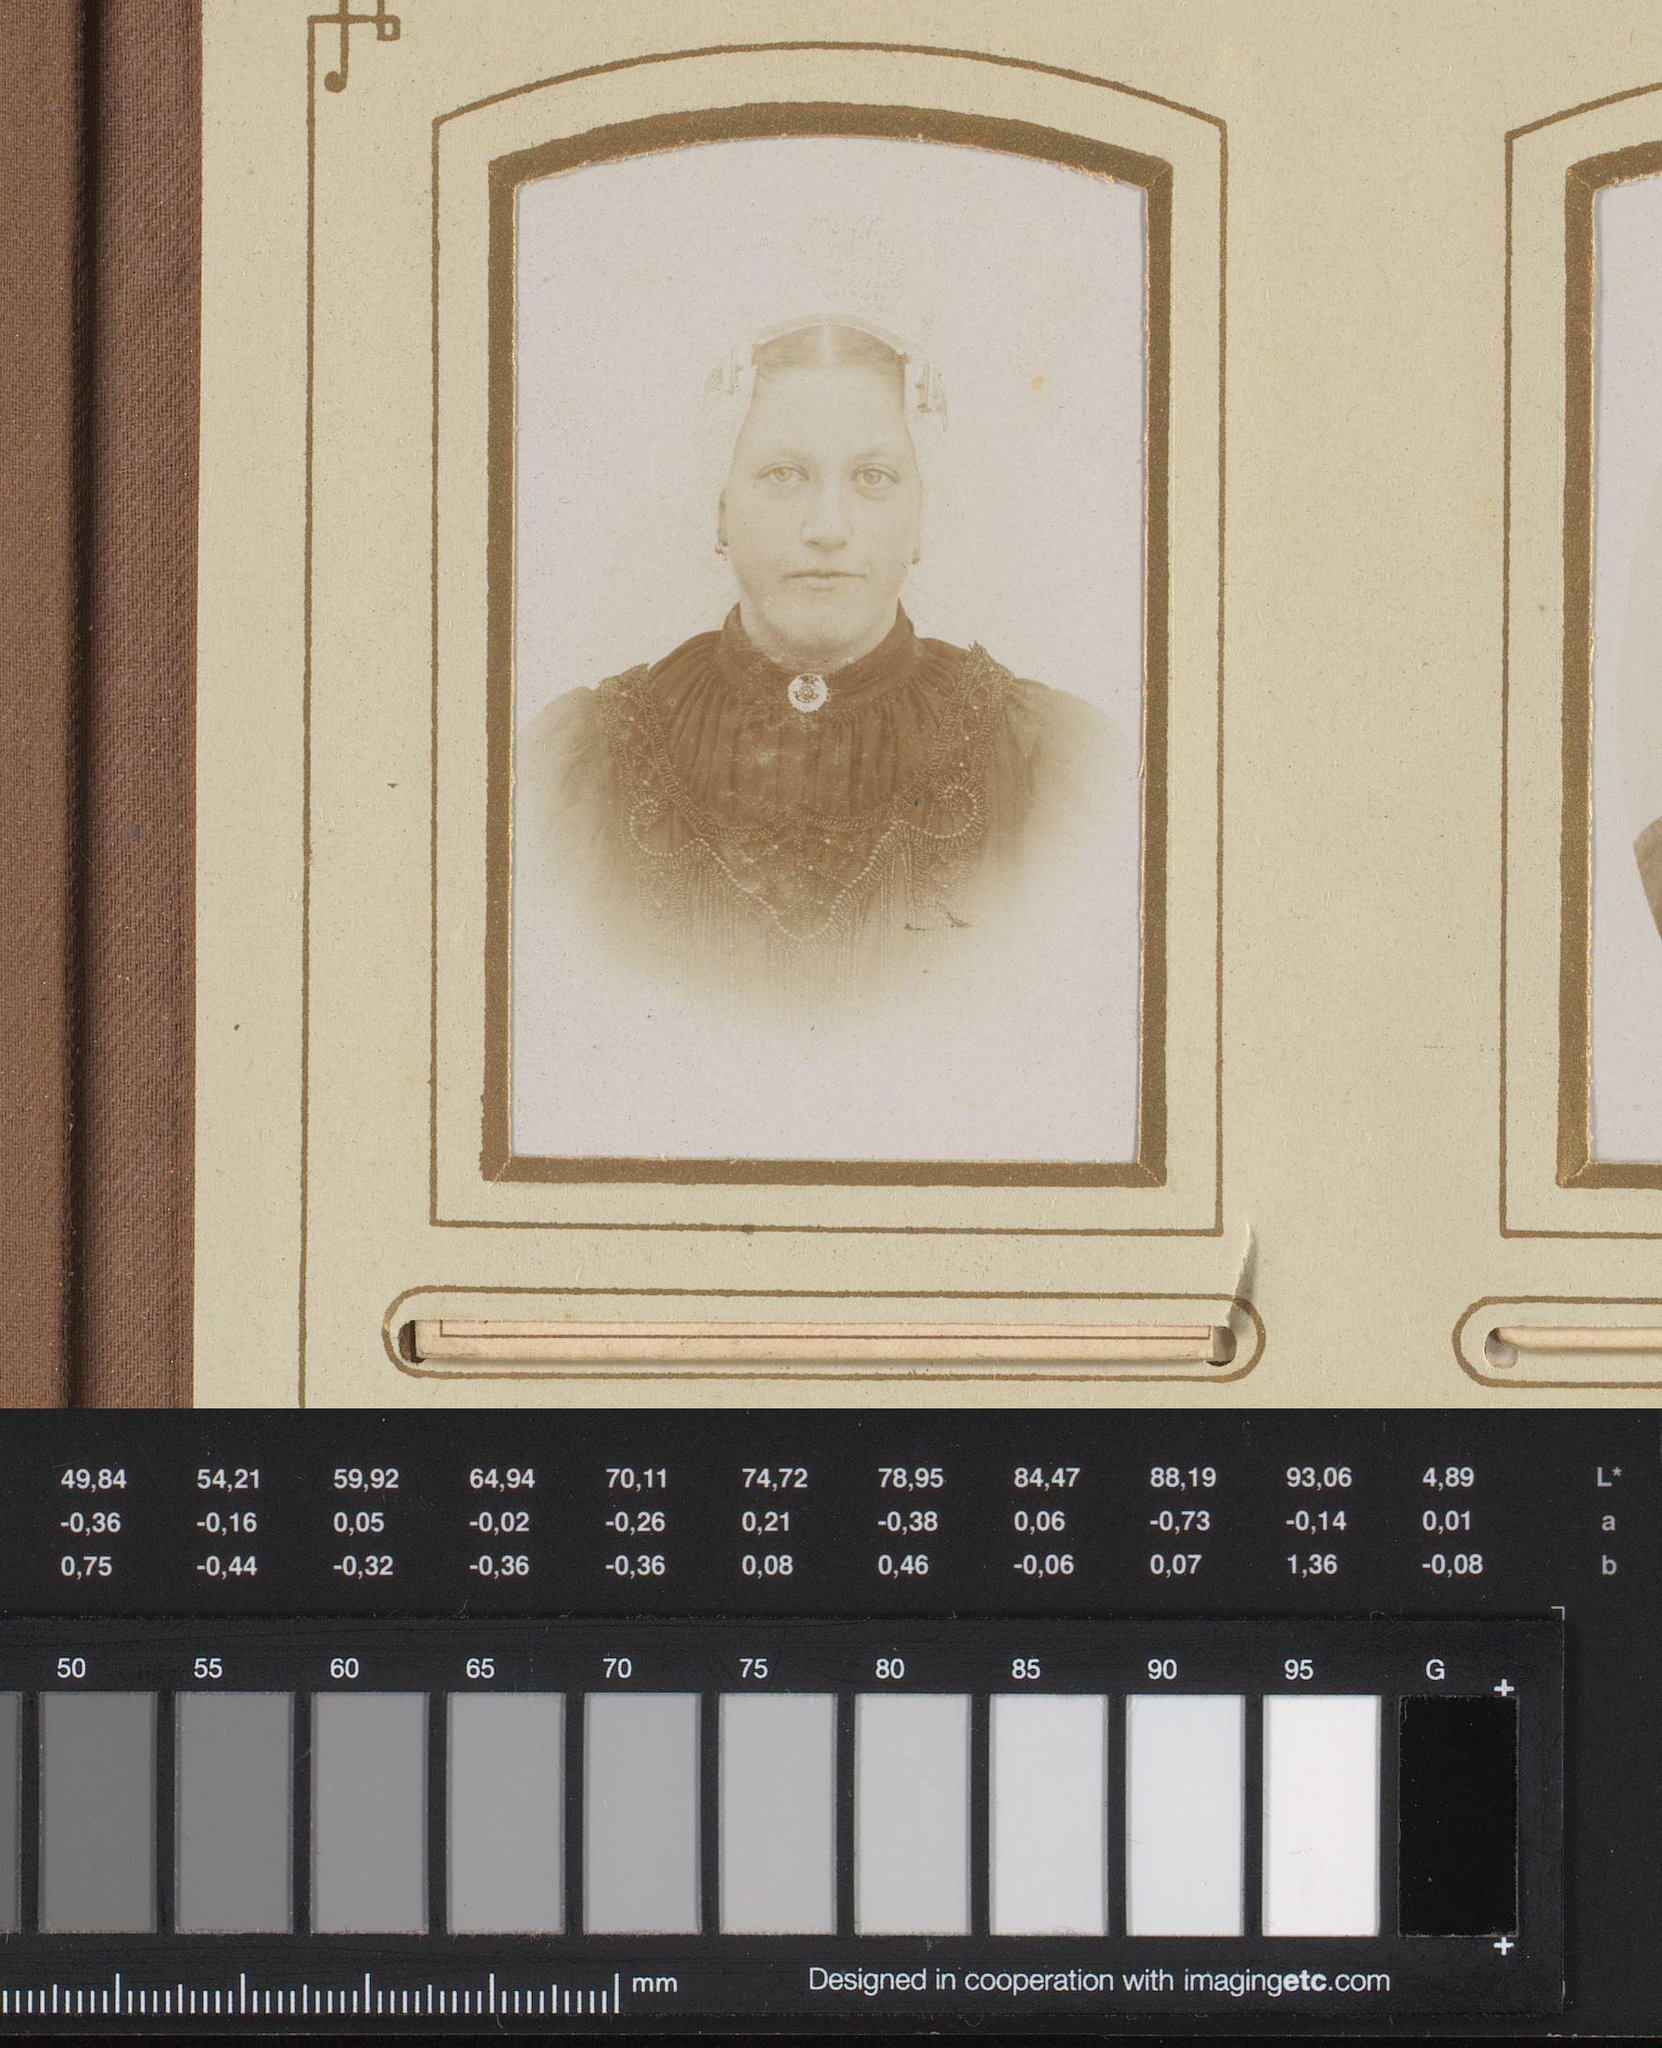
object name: photograph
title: Portret van een vrouw met witte klederdrachtmuts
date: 1890-1910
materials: cardboard, photographic support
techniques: collodion silver print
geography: amsterdam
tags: historical persons - bb - woman, head-gear: cap, folk costume, regional costume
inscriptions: inscription: ‘D. Fraenkel & Zoon/ PHOTOGRAPHEN/ Amsterdam 43.Commelinstraat 43./ Specialiteit in vergrootingen van deze Portretten/ kunnen steeds nabesteld worden.’